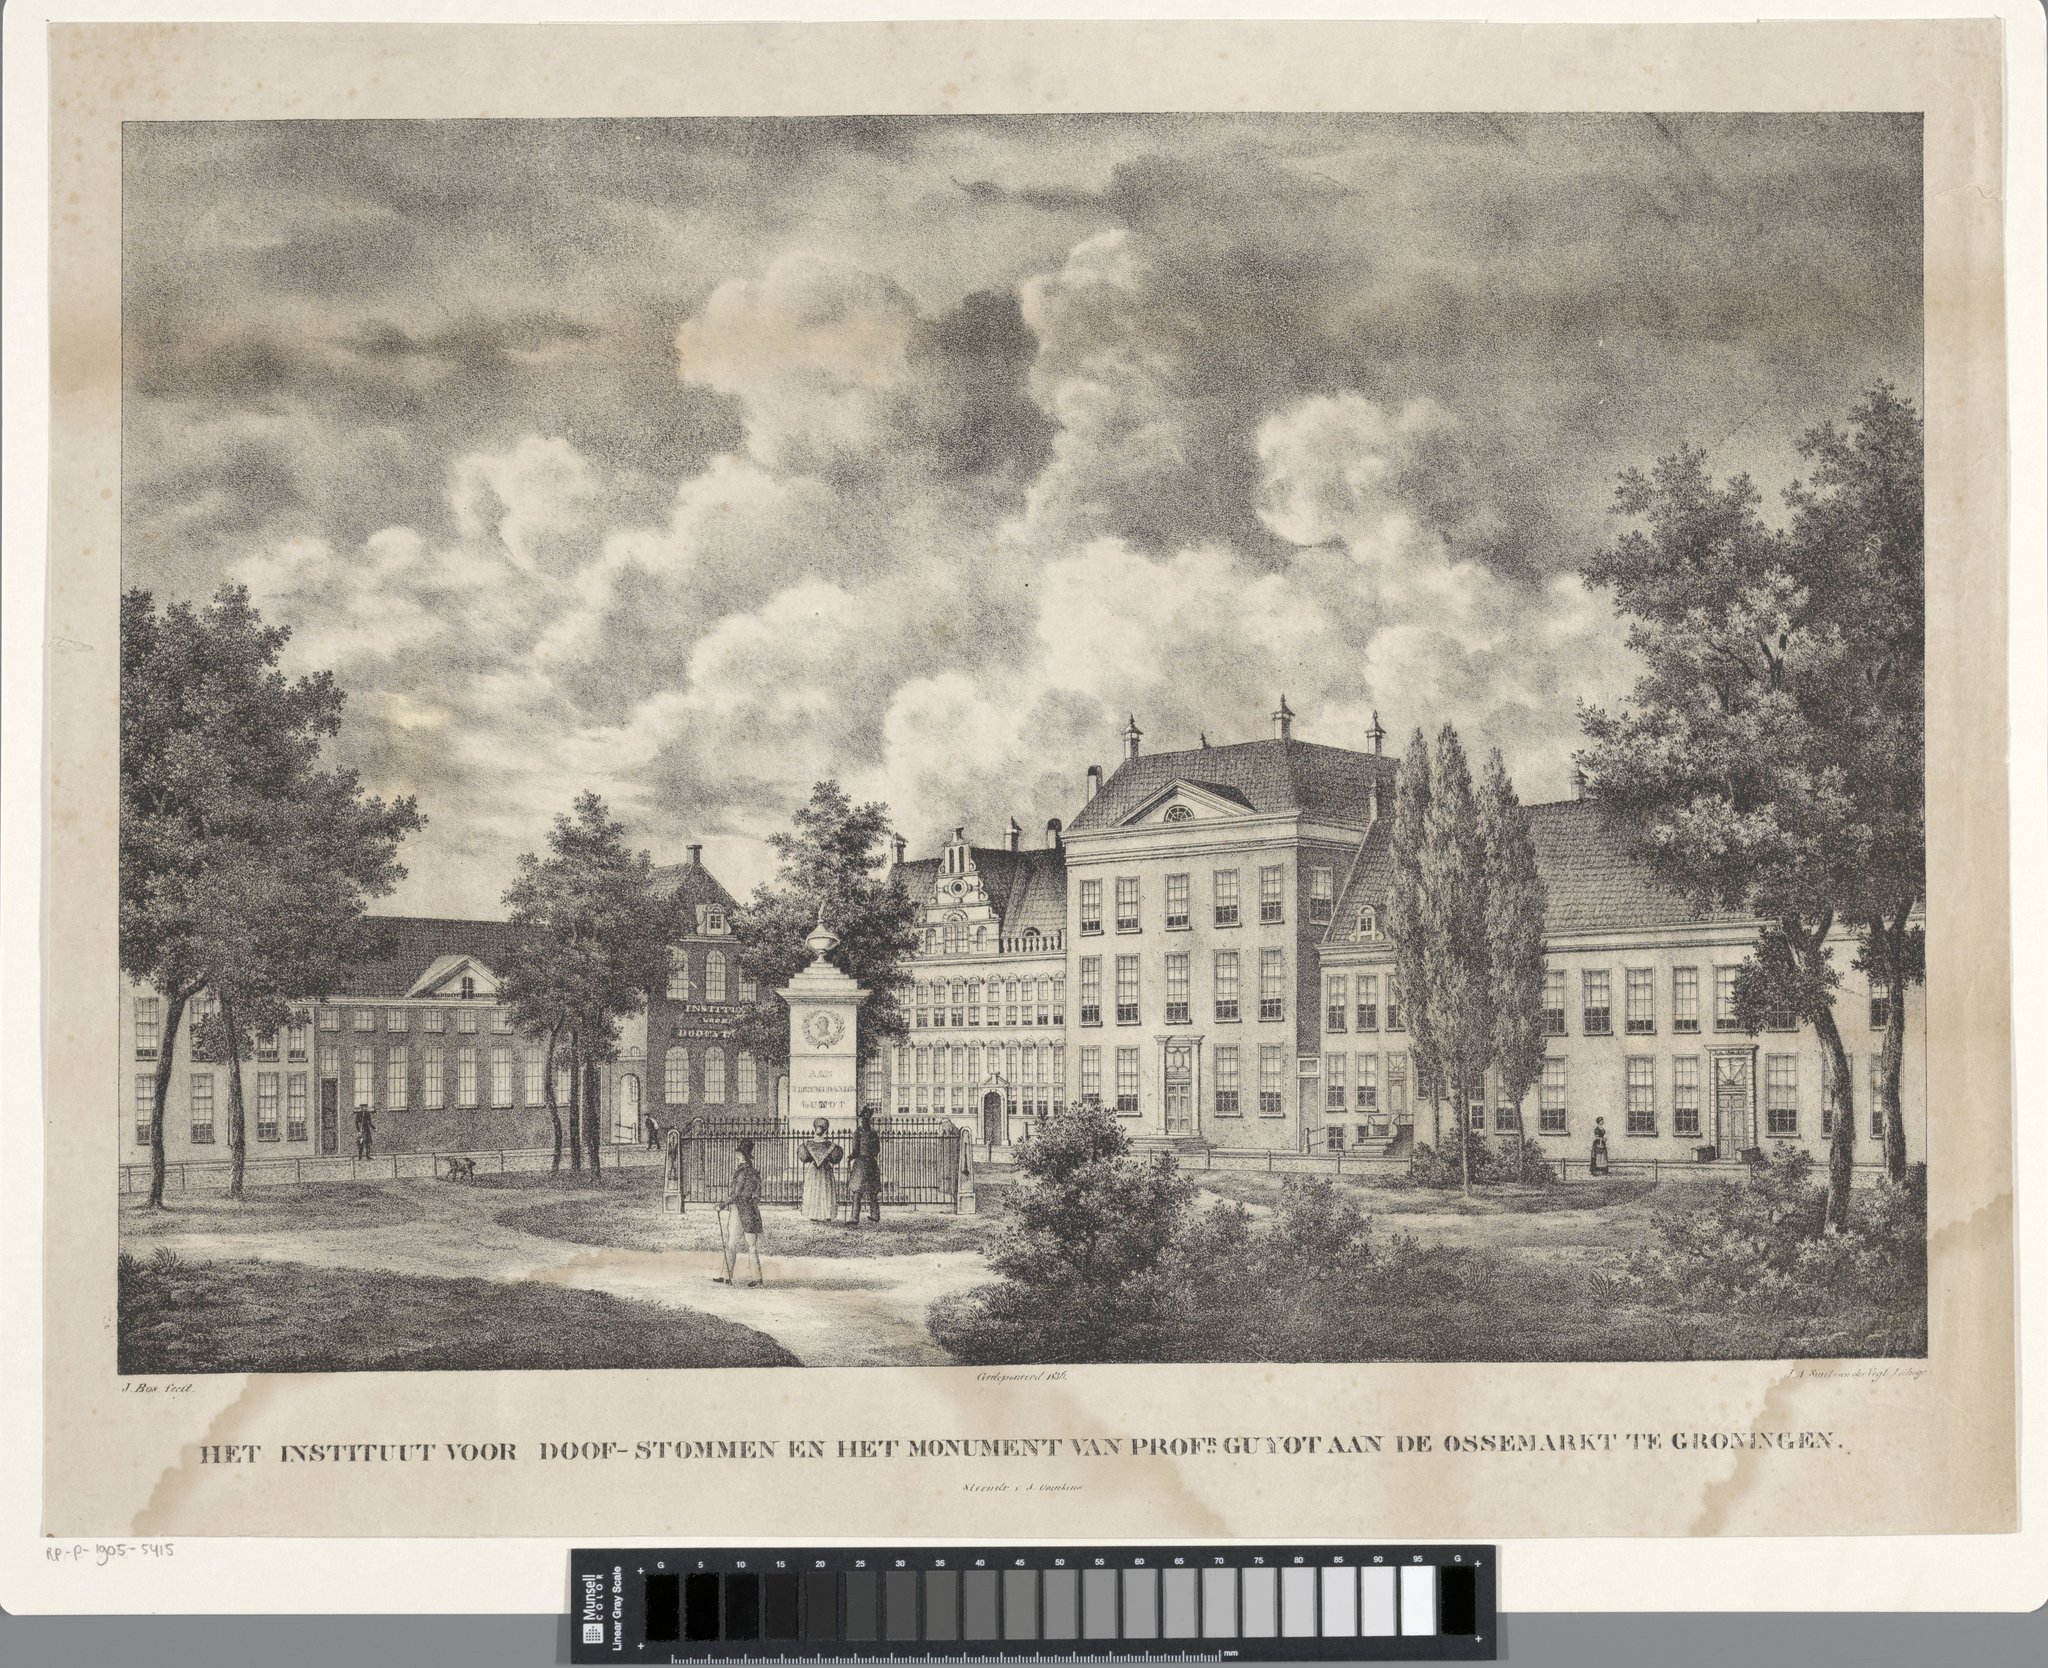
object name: print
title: Het instituut voor Doof-stommen en het monument van prof.r Guyot aan de Ossemarkt te Groningen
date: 1836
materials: paper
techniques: lithograph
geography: netherlands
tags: france, deaf, deafness, specialized institutions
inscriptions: collector's mark: Lugt 2228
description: Gezicht op de Ossenmarkt met het Instituut voor Doofstommen, het Henri Daniel Guyot Instituut, te Groningen. In het midden het gedenkteken onthuld op 21 november 1829 voor Henri Daniel Guyot, de stichter van de eerste Nederlandse doveninstituut.